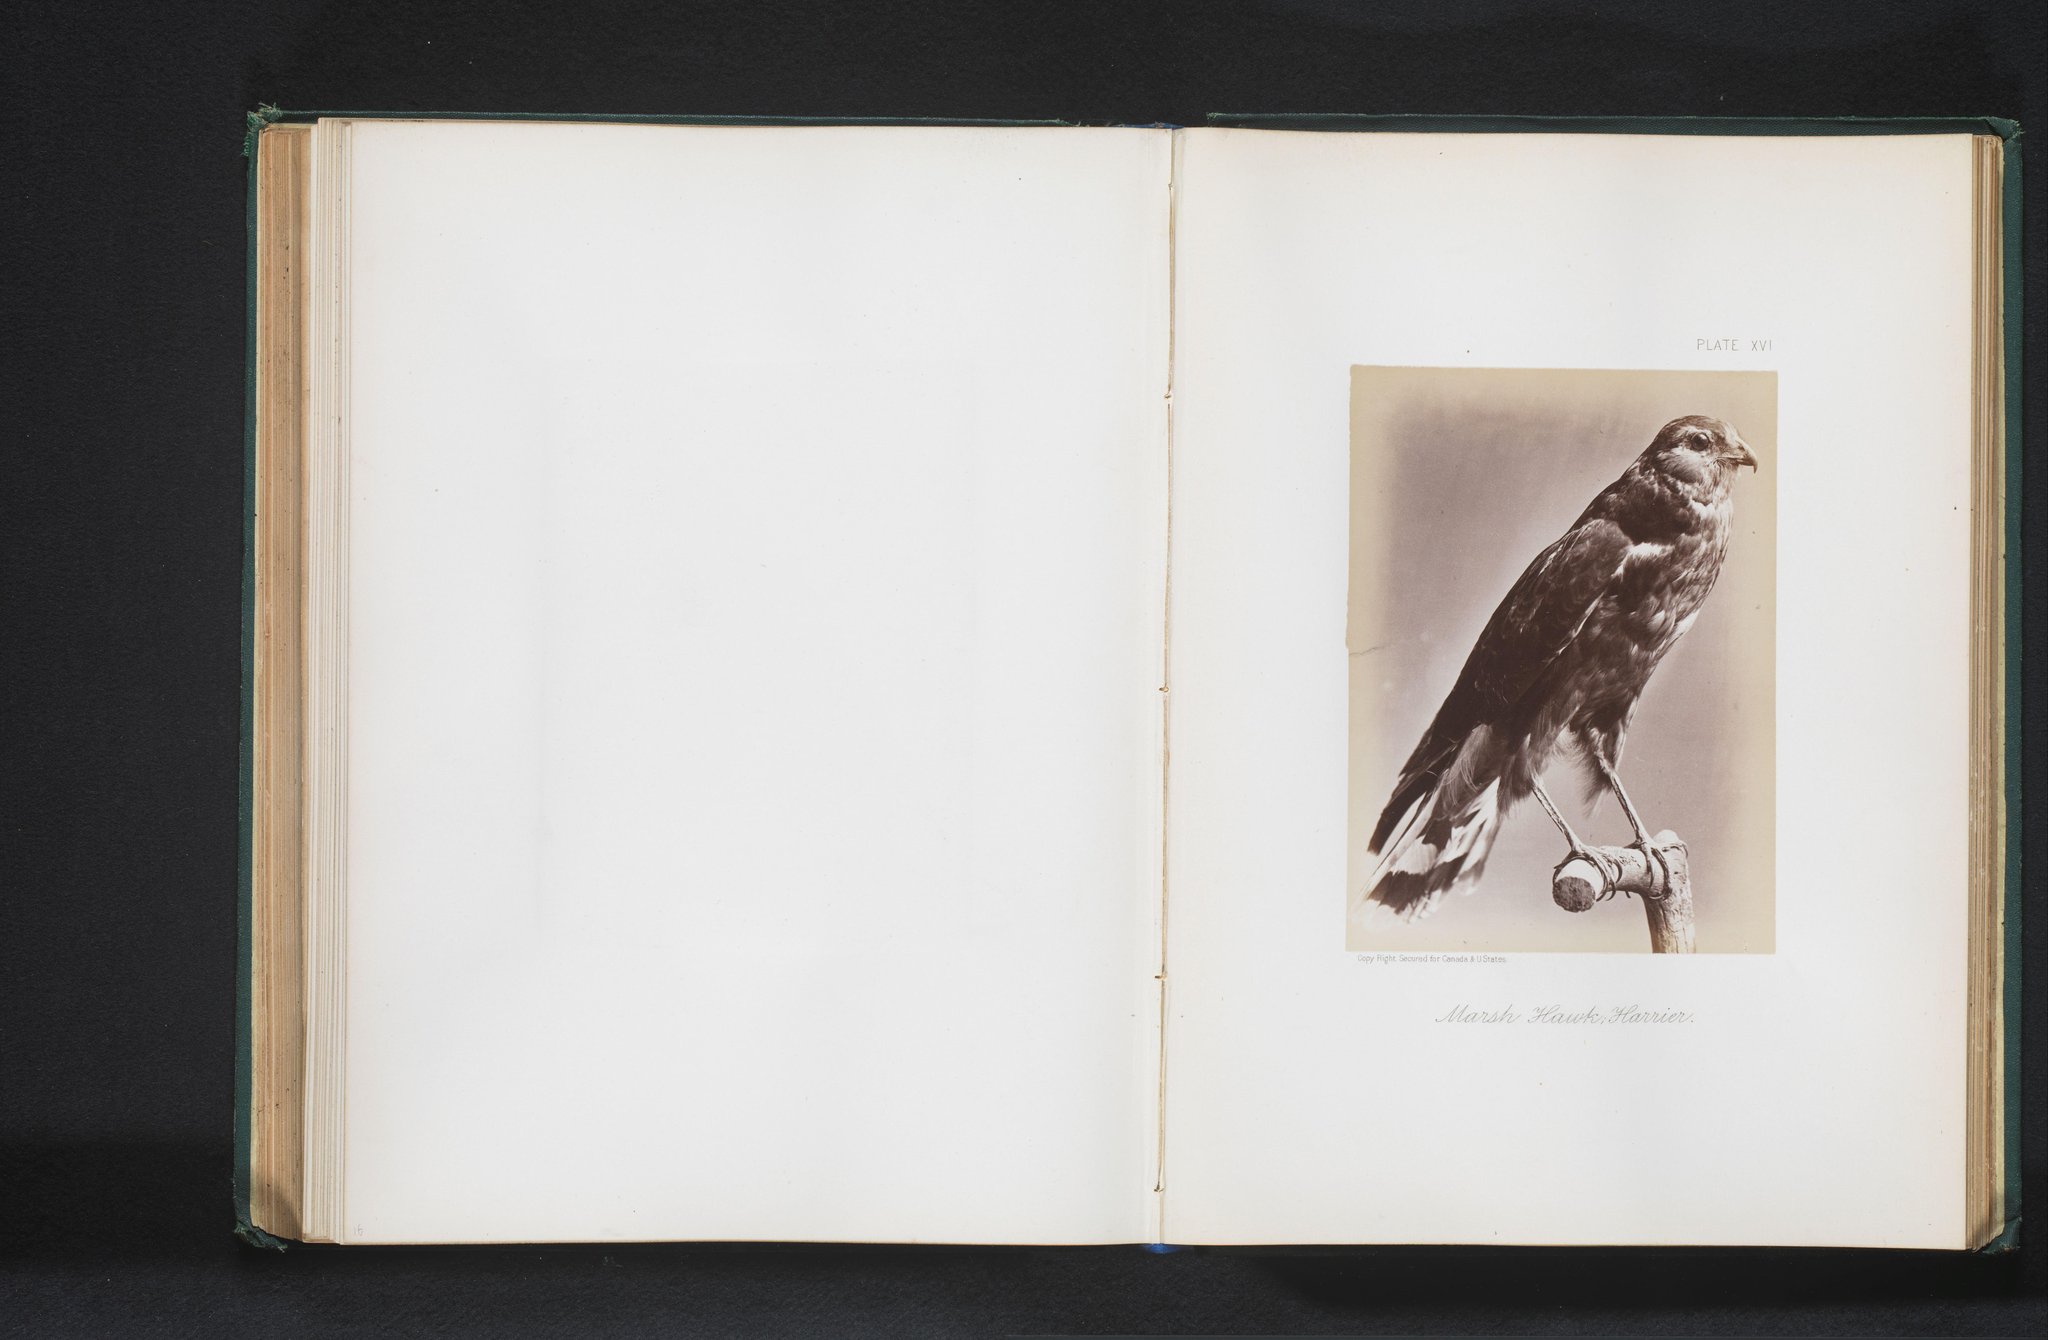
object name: photograph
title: Marsh Hawk; Harrier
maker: william notman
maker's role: fotograaf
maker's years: 1826-1891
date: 1871-1876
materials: paper, photographic support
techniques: albumen print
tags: collection of animals, predatory birds: hawk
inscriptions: number: ‘PLATE XVI’, inscription: ‘Copy Right Secured for Canada & U.States’